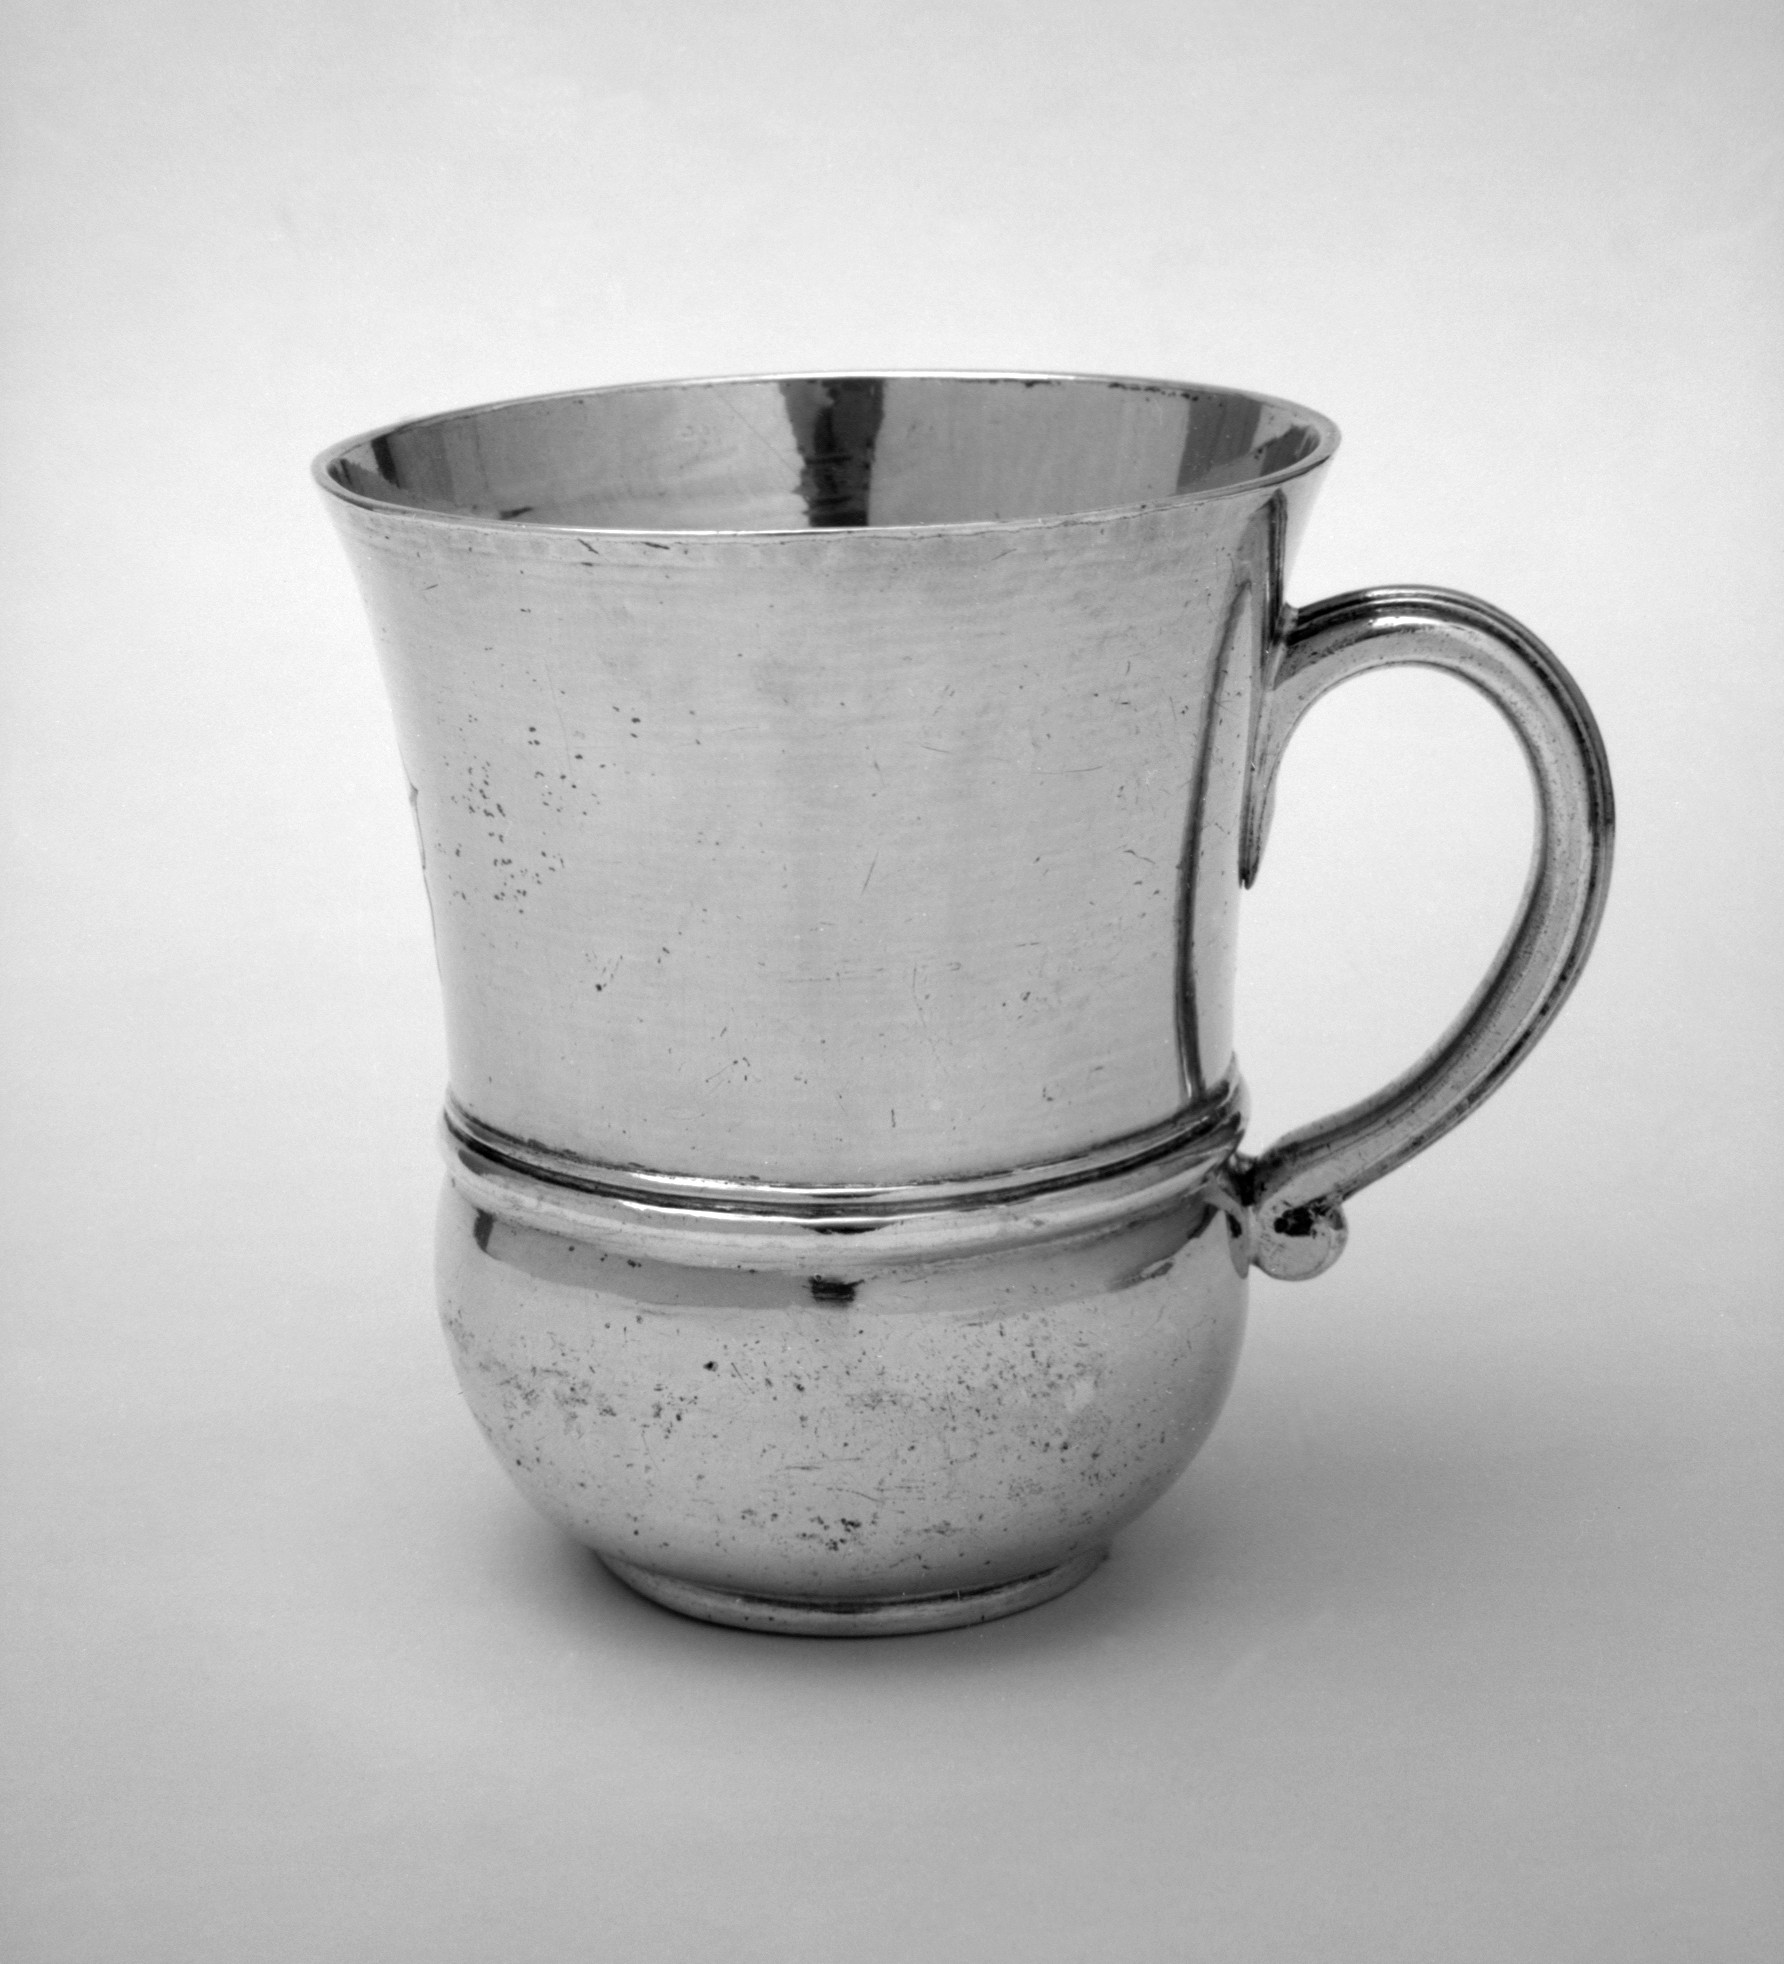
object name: mug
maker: i. s., london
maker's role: maker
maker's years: 1684-1689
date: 1684-1685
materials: silver gilt